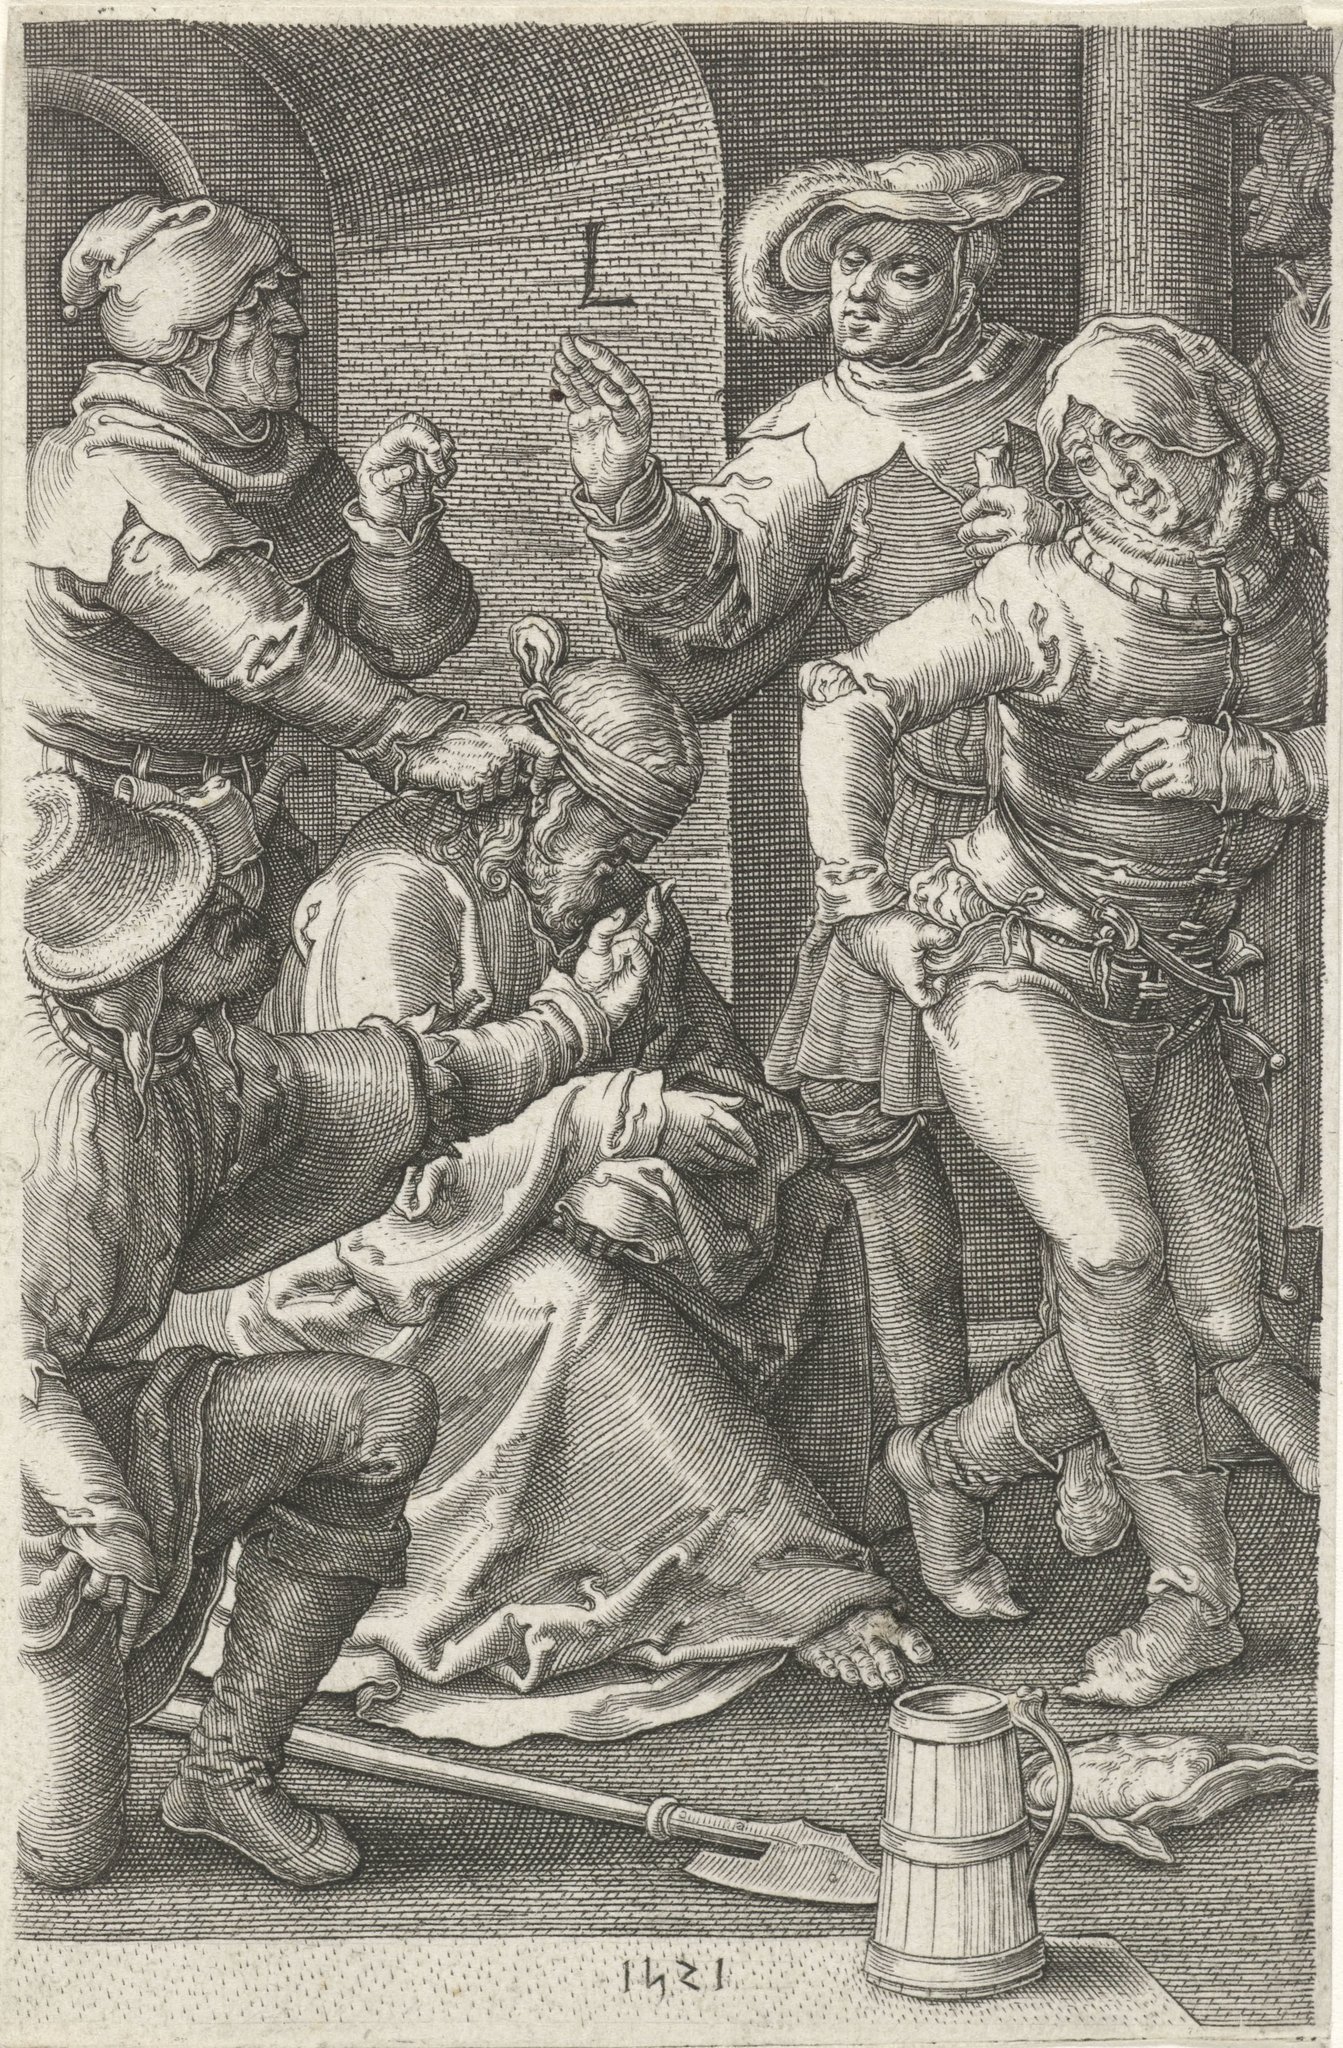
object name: print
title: Passie van Christus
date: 1613-1622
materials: paper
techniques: engraving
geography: amsterdam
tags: mockings of christ, who may be blindfolded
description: De geblinddoekte Christus wordt door vier mannen bespot. Op de voorgrond een kruik.